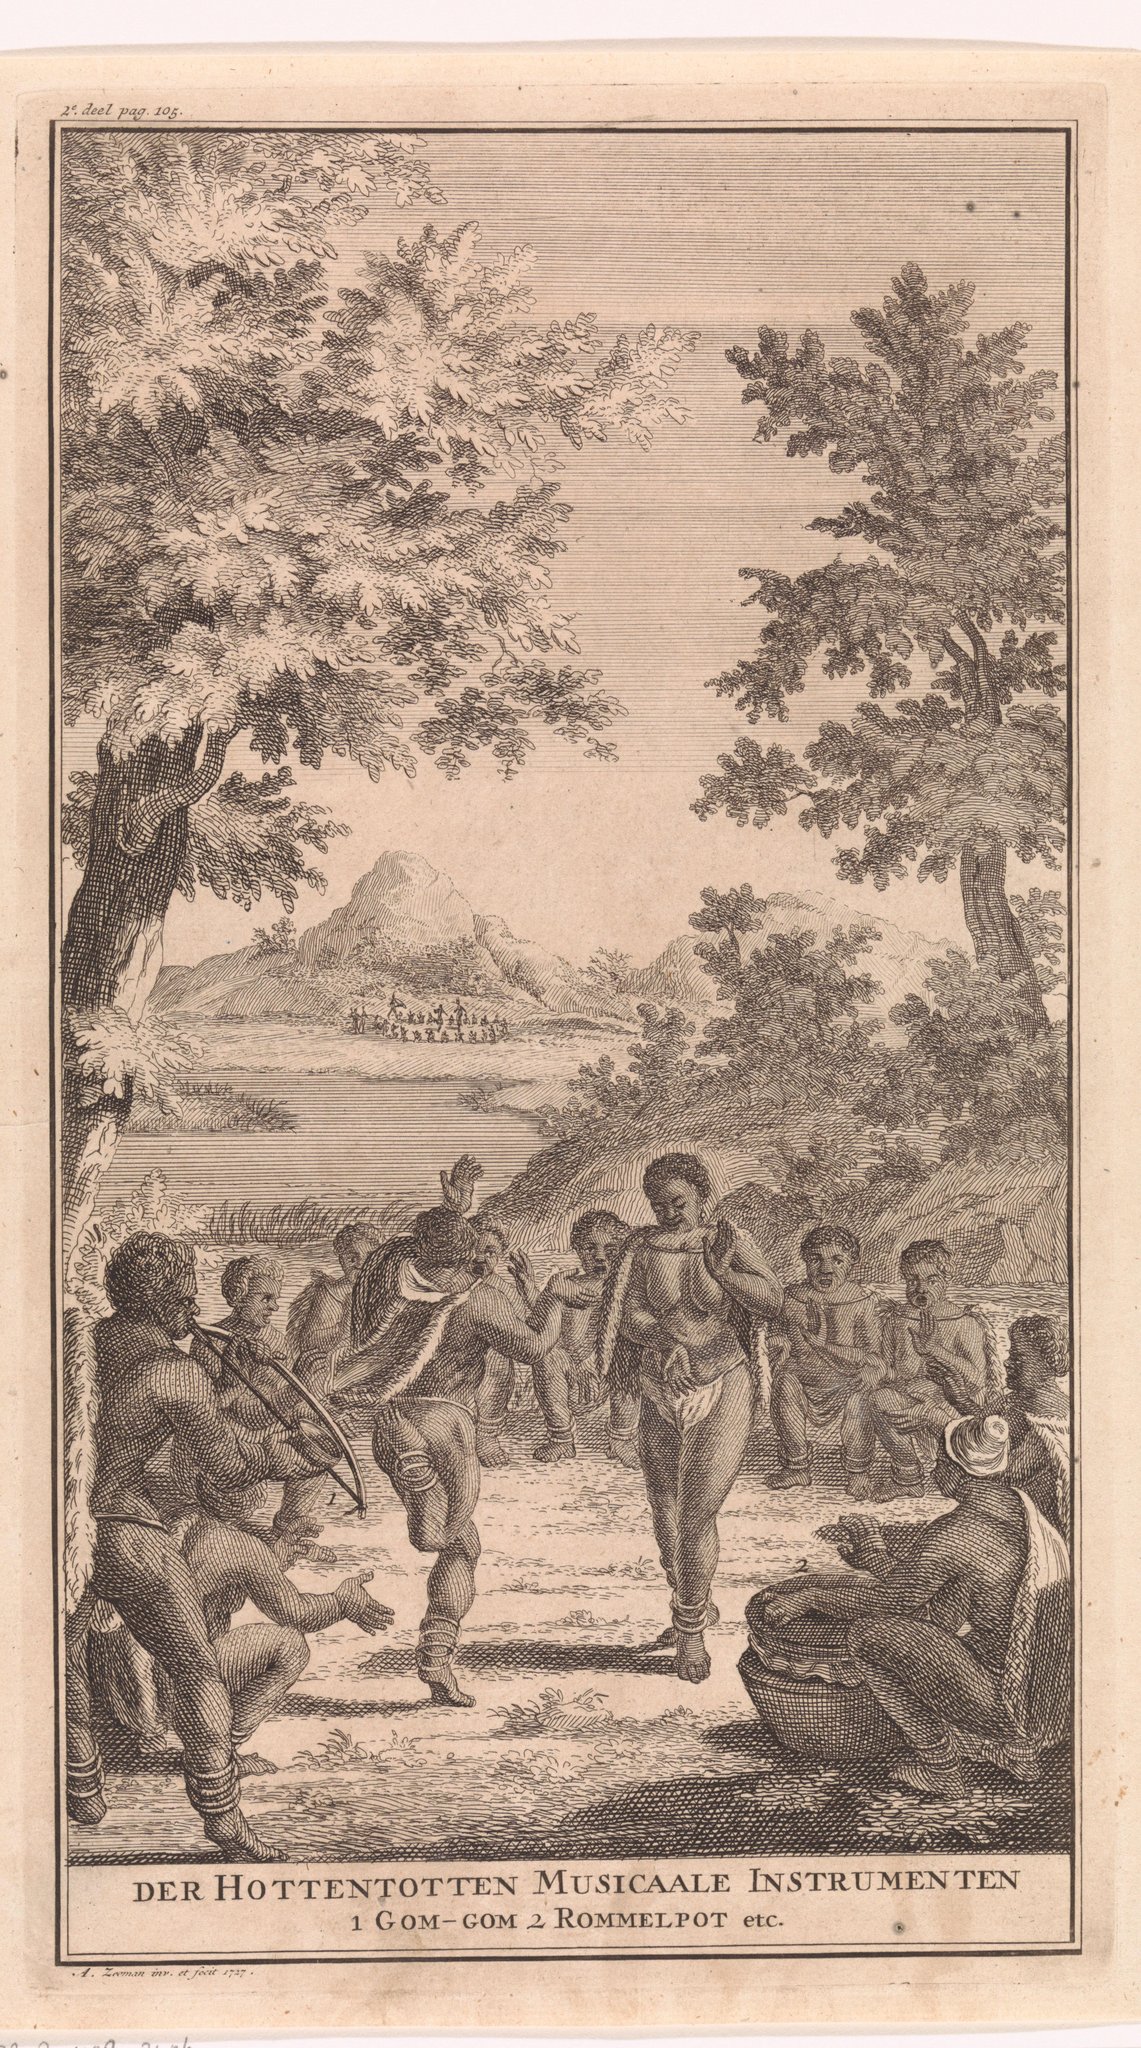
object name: book illustration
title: Der Hottentotten Musicaale Instrumenten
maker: abraham zeeman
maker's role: print maker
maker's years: 1695-1754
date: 1727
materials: paper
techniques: engraving, etching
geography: amsterdam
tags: musical instruments; group of musical instruments, khoikhoi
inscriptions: collector's mark: Lugt 2228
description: Prent uit: Kolb, Peter. Naaukeurige en uitvoerige beschryving van de Kaap de Goede Hoop (...) nevens een (...) beschryving van den oorsprong der Hottentotten. 2 dln. Amsterdam: Balthazar Lakeman, 1727, dl. 2.